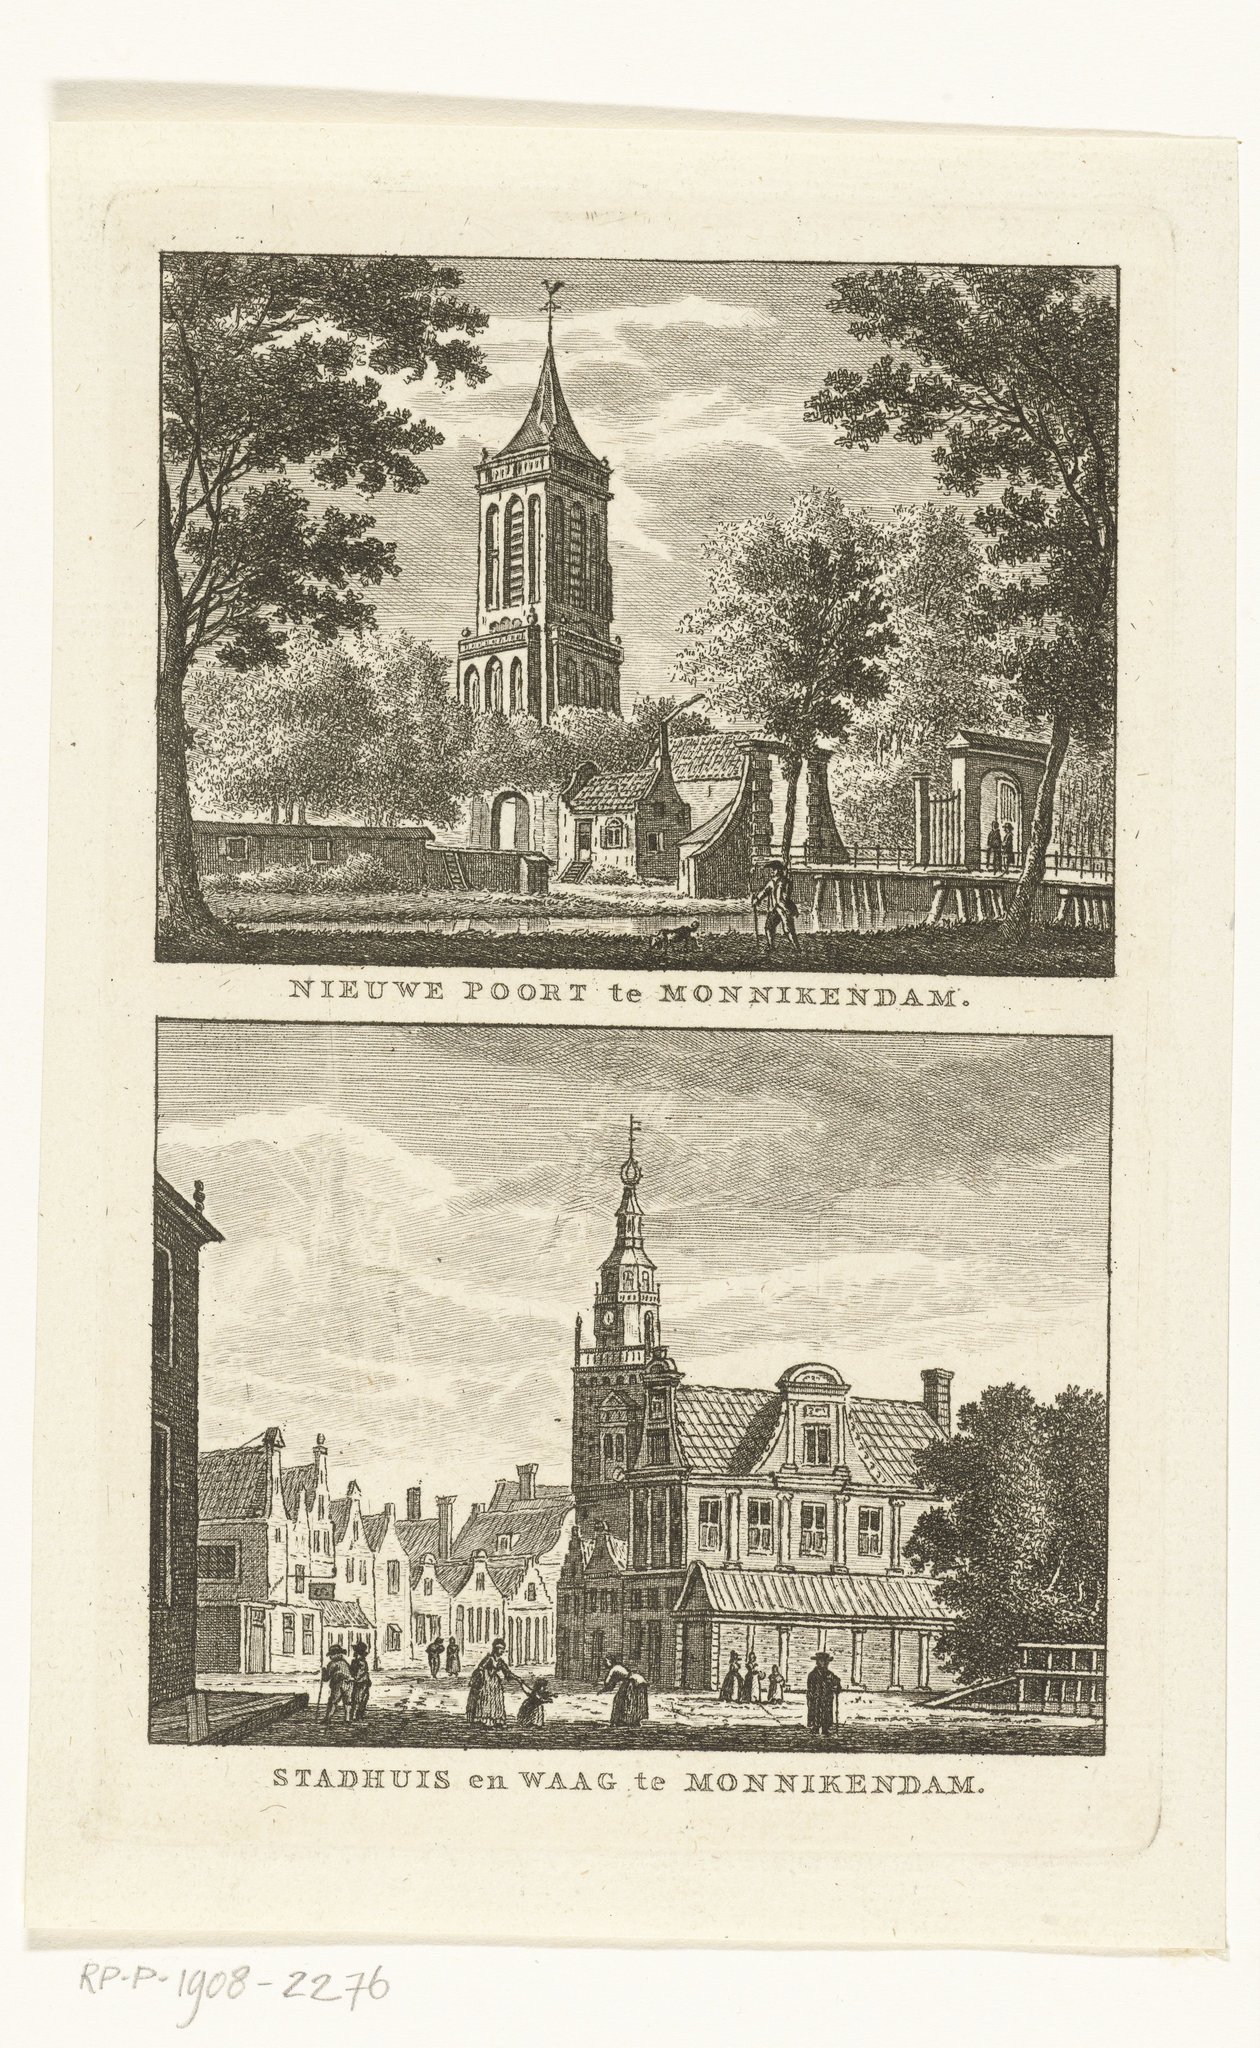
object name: print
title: Stadhuis en Waag te Monnikendam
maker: carel frederik bendorp (i)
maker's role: print maker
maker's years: 1736-1814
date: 1786-1792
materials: paper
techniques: etching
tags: weigh-house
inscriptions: collector's mark: Lugt 2228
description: Prent uit: Vaderlandsche gezichten, of afbeeldingen van den tegenwoordigen staat der Vereenigde Nederlanden (…). Amsterdam: Hendrik Gartman, Willem Vermandel en Jan Willem Smit, 1786-1792. Uitgegeven in afleveringen met ieder een eigen bifolium en inhoudsopgave. Alle prenten in deze publicatie zijn gegraveerd door Carel Frederik Bendorp (I) en, in de meeste gevallen, gebaseerd op tekeningen van Jan Bulthuis.